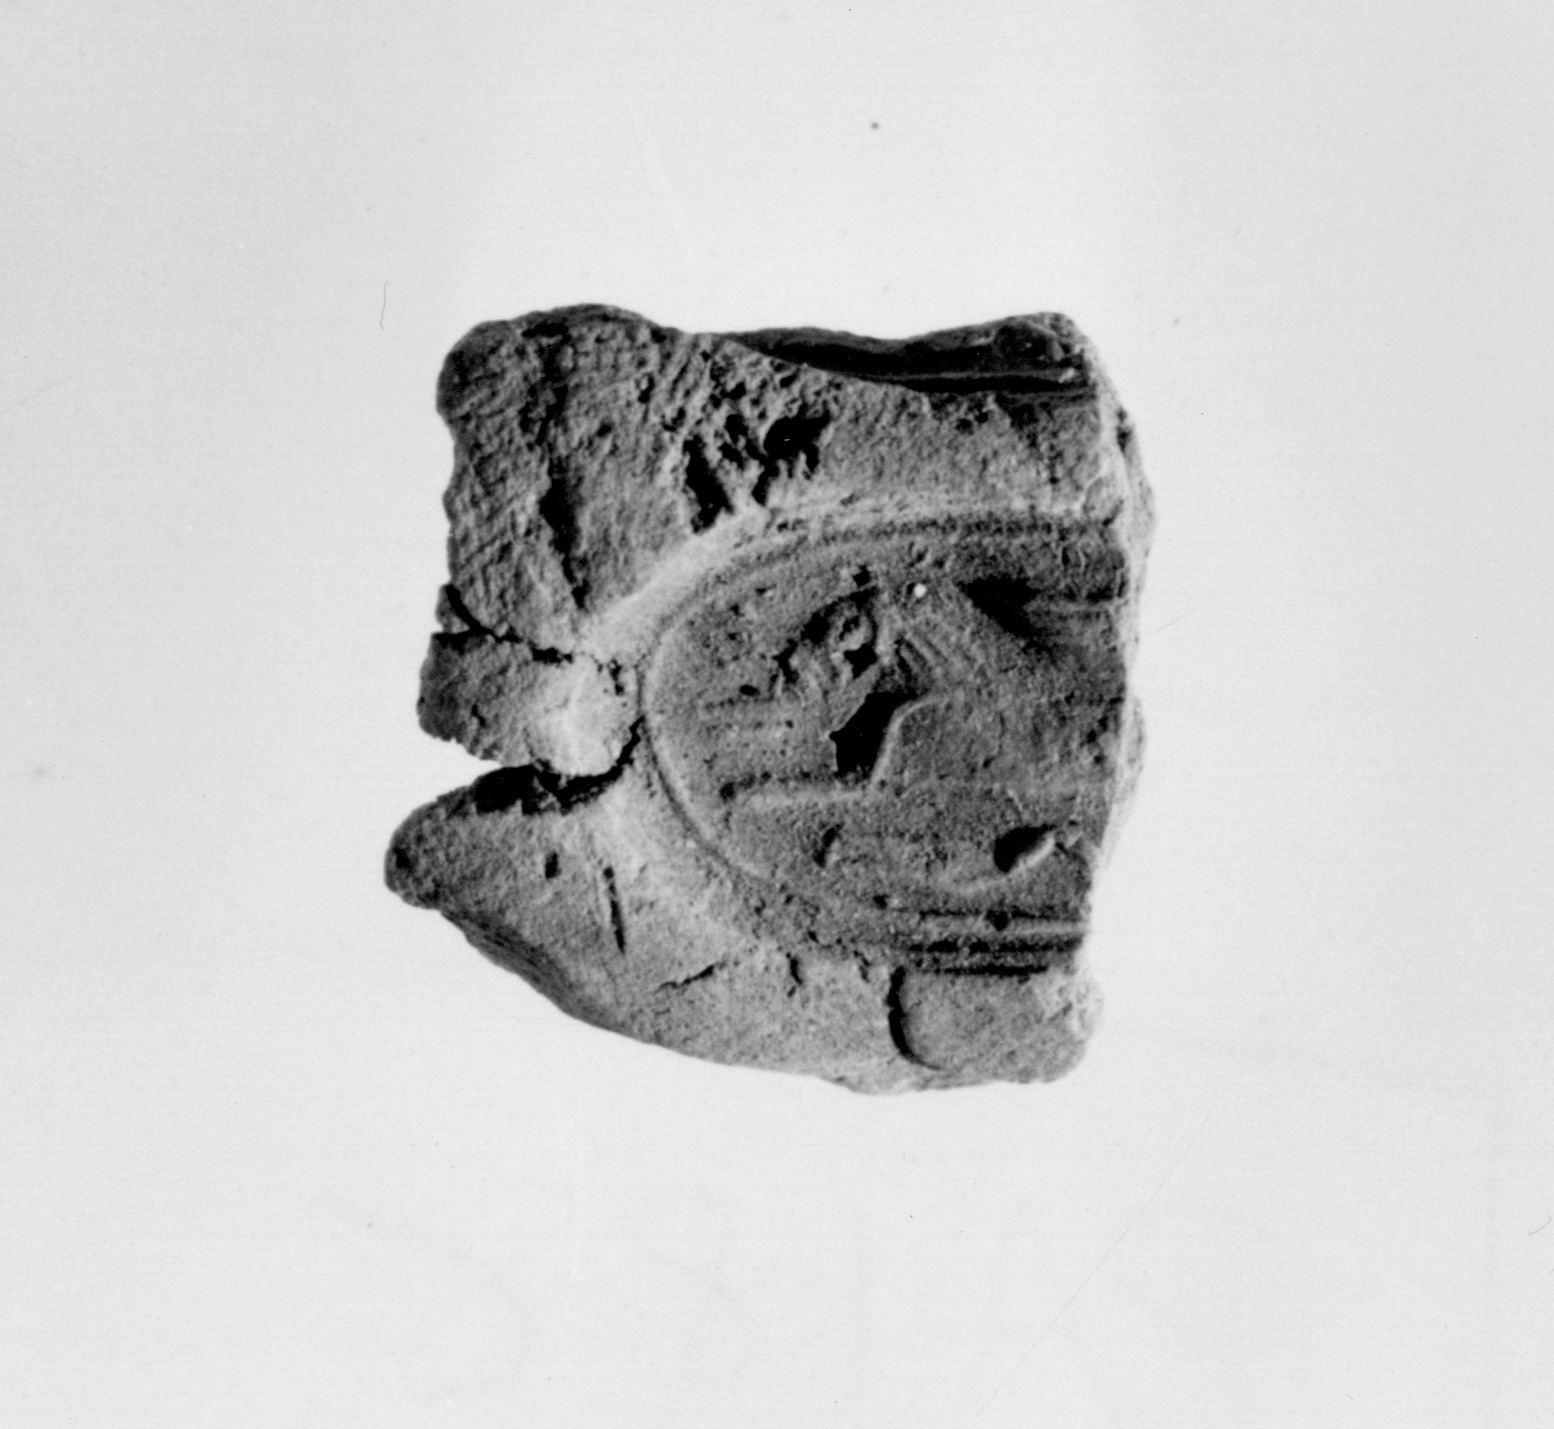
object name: sealing, recumbant lion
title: Document Sealing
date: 1390-1352 BCE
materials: mud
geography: egypt